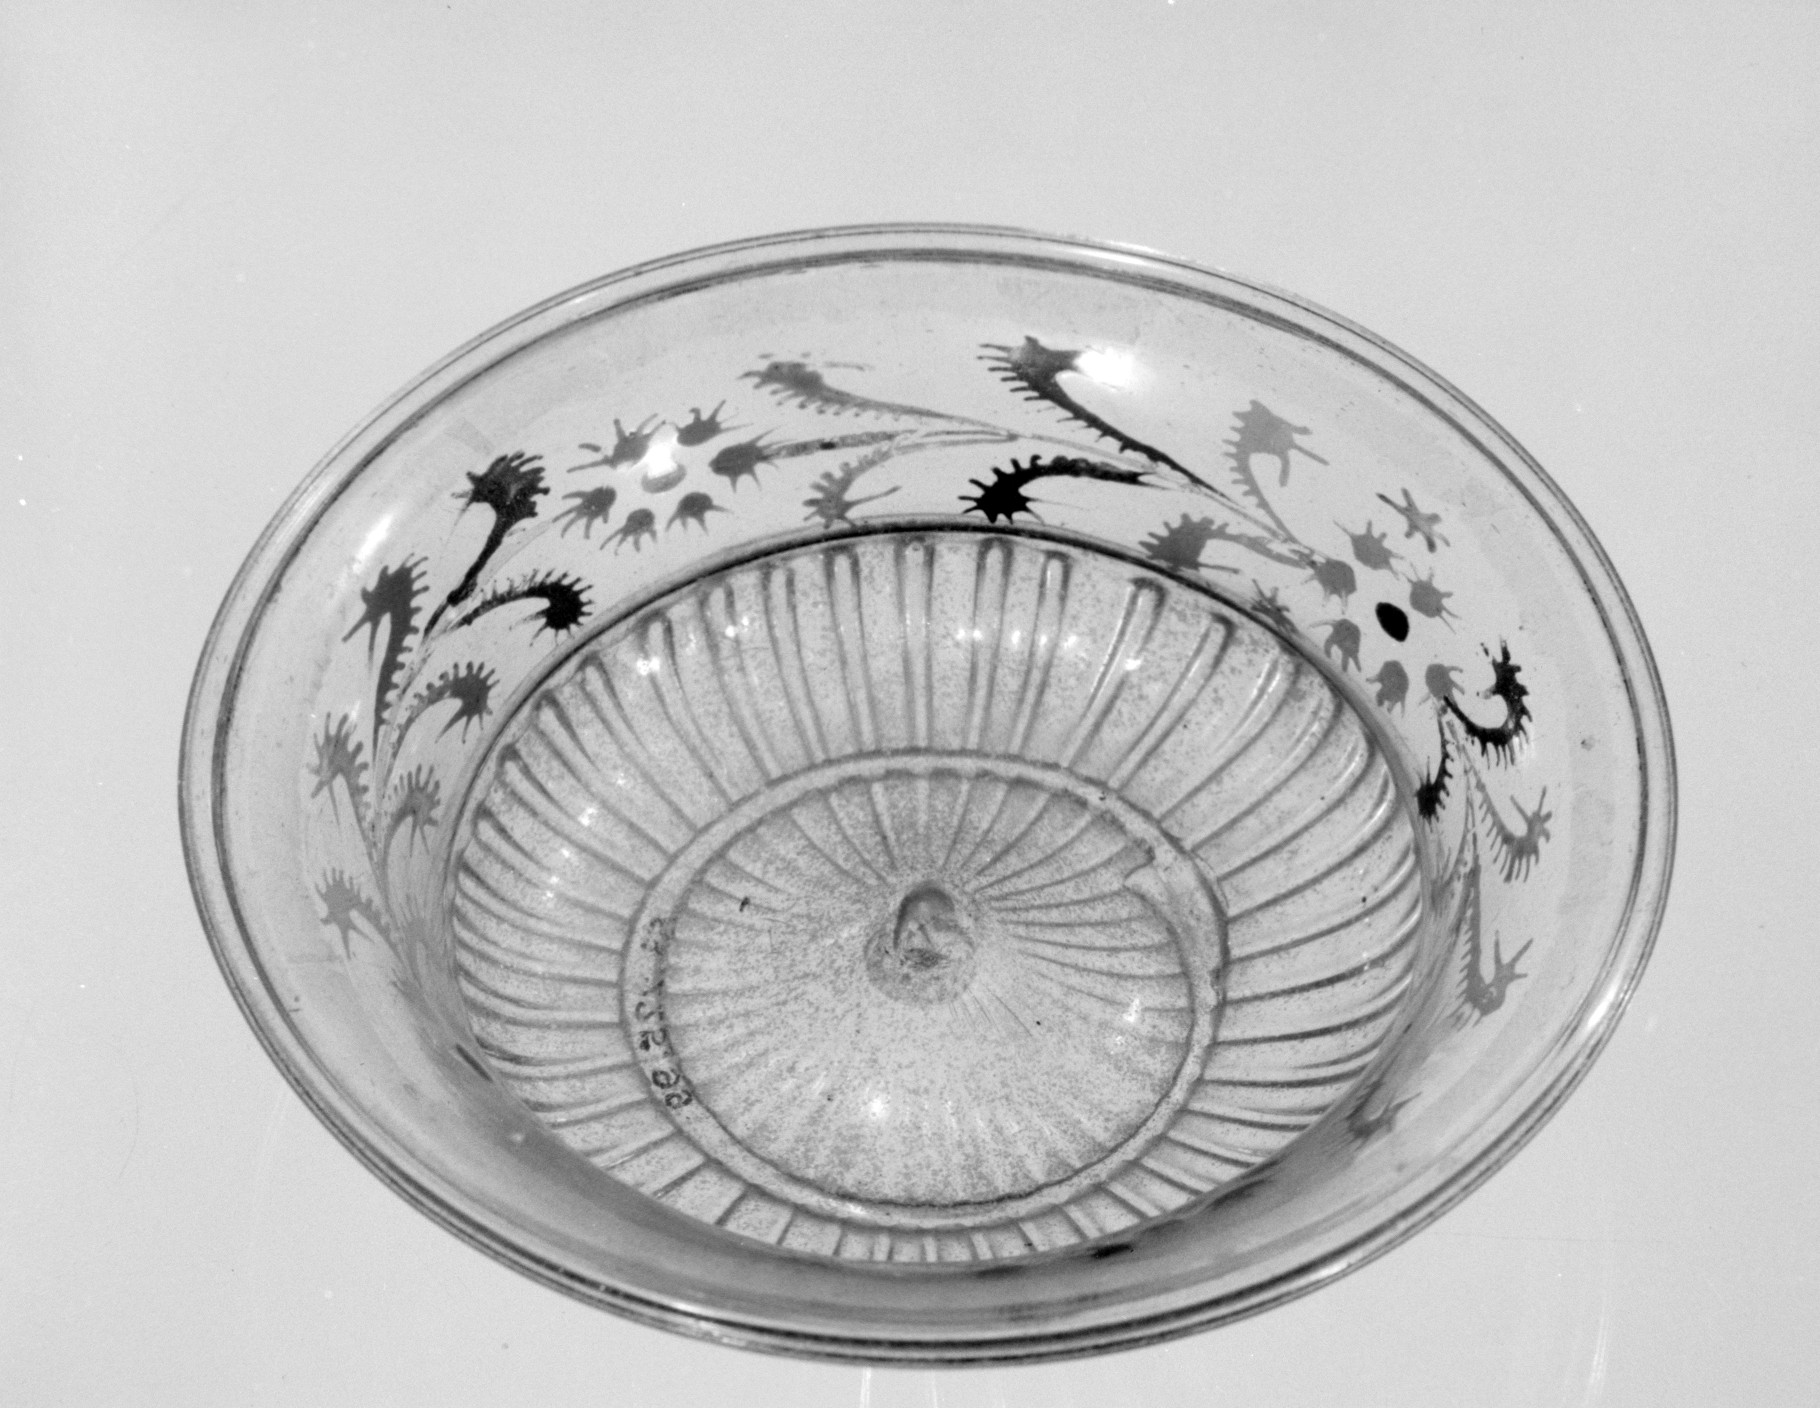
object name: bowl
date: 1467-1533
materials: glass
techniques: enamel